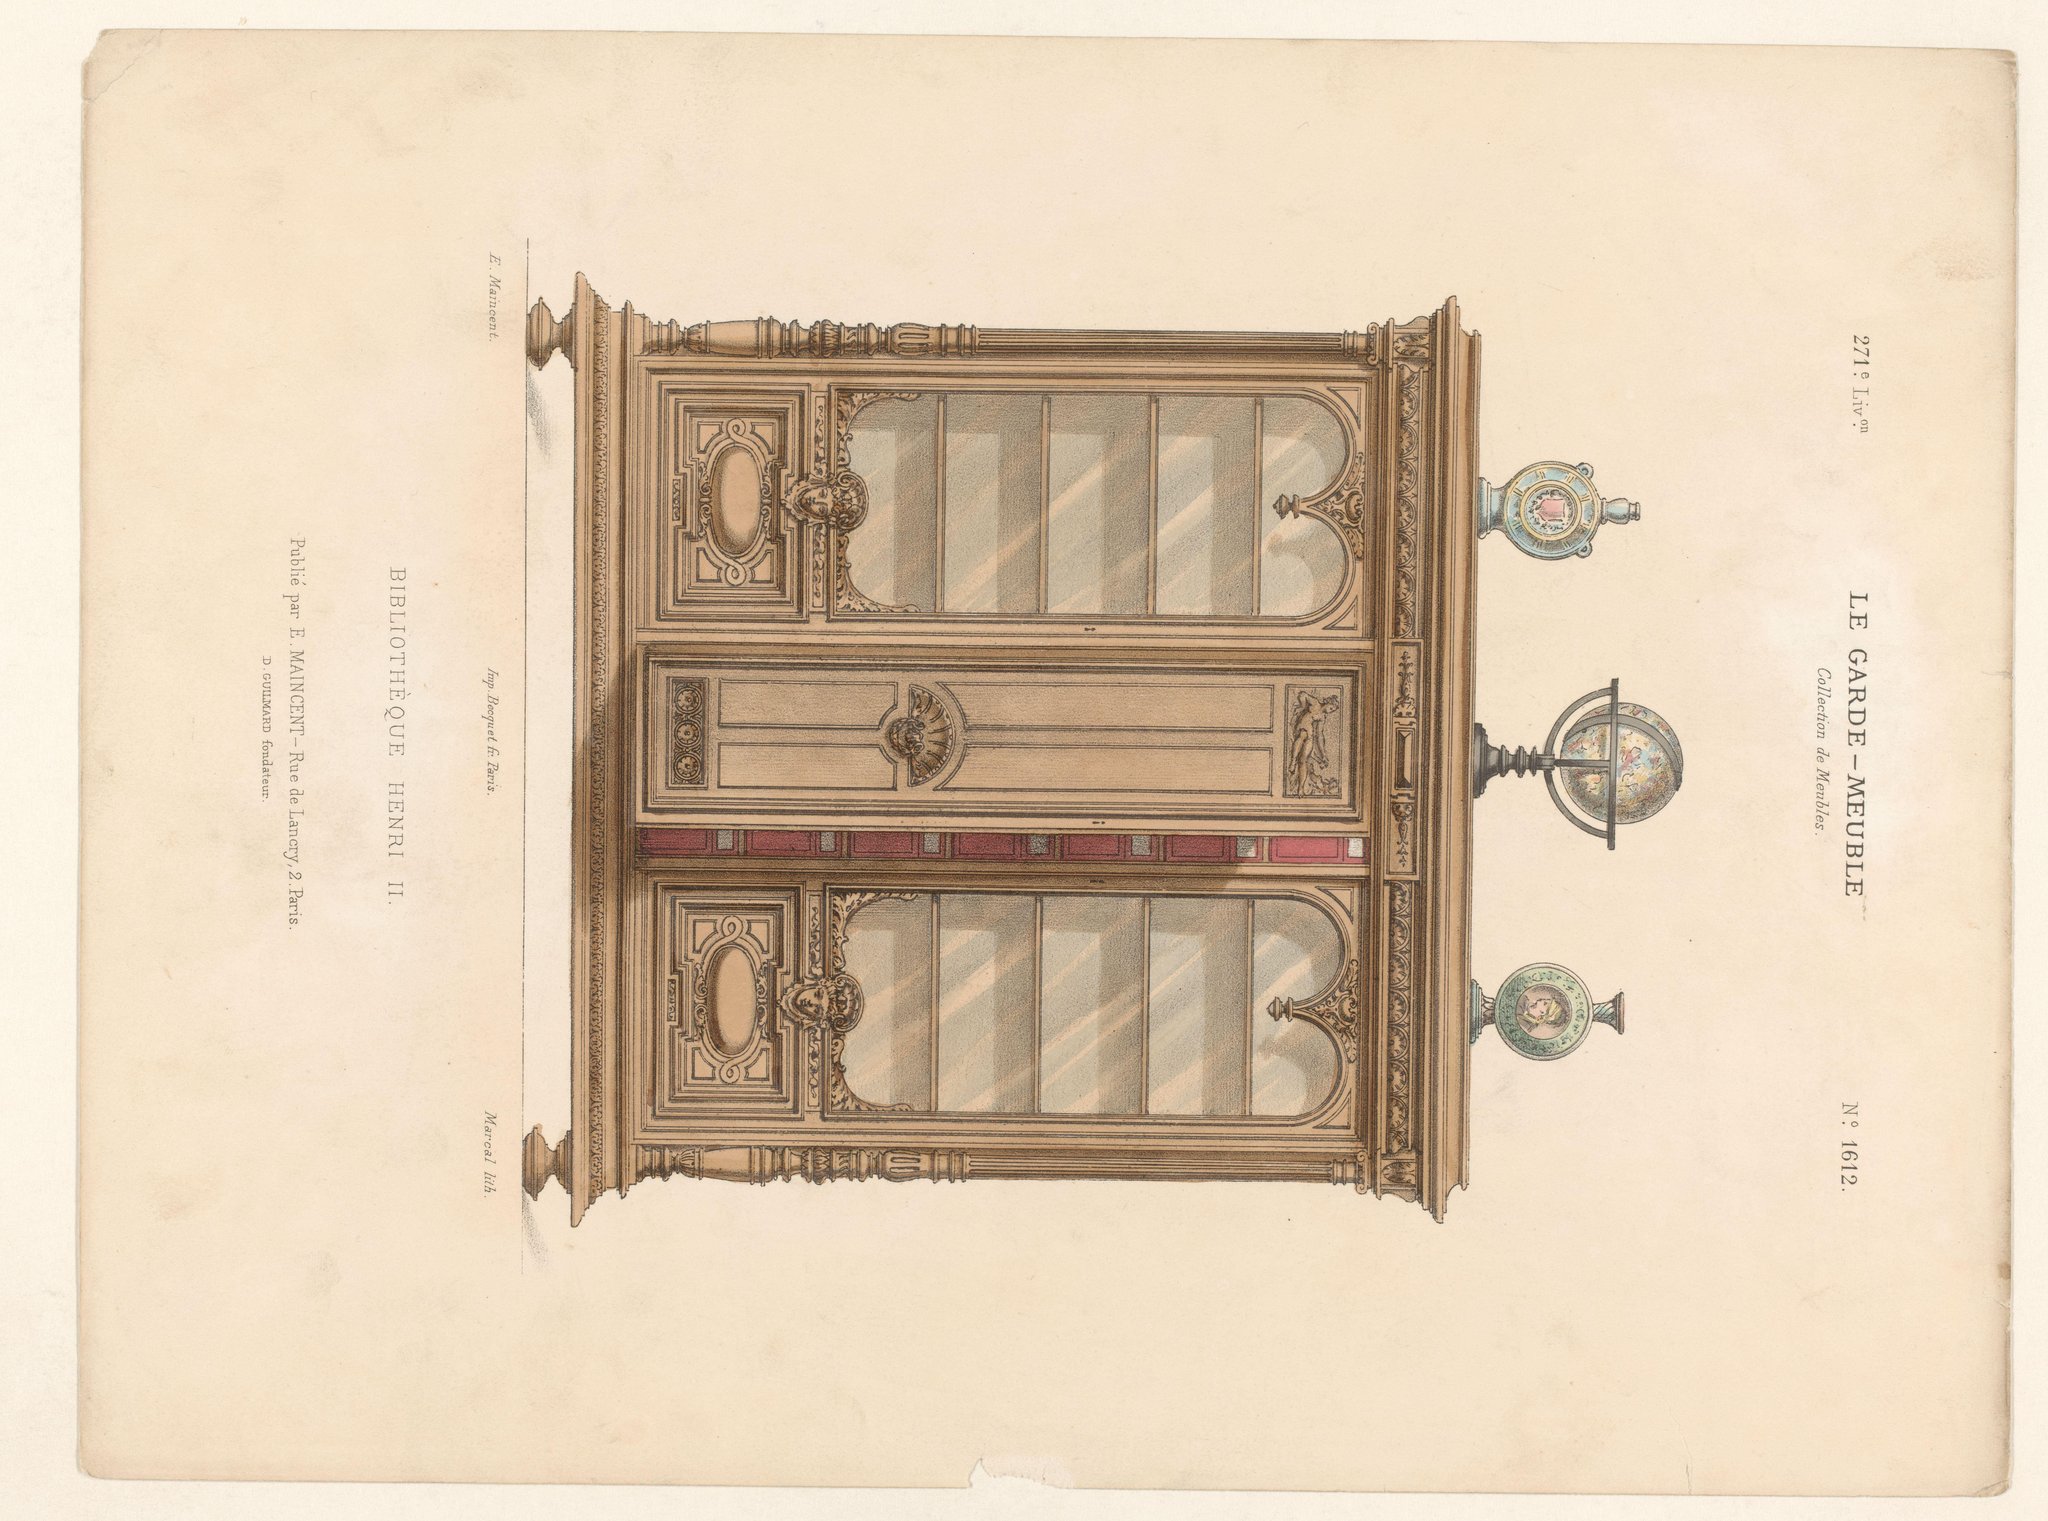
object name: print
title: Boekenkast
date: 1885-1895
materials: paper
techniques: hand coloring, lithograph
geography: paris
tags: bookcase, with doors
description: Ieder Livraison in de serie Le Garde-Meuble bevat negen platen: drie 'sièges' (zitmeubels), drie 'meubles' (diverse meubels zoals tafels en kasten) en drie 'tentures' (gordijnen en draperieën).